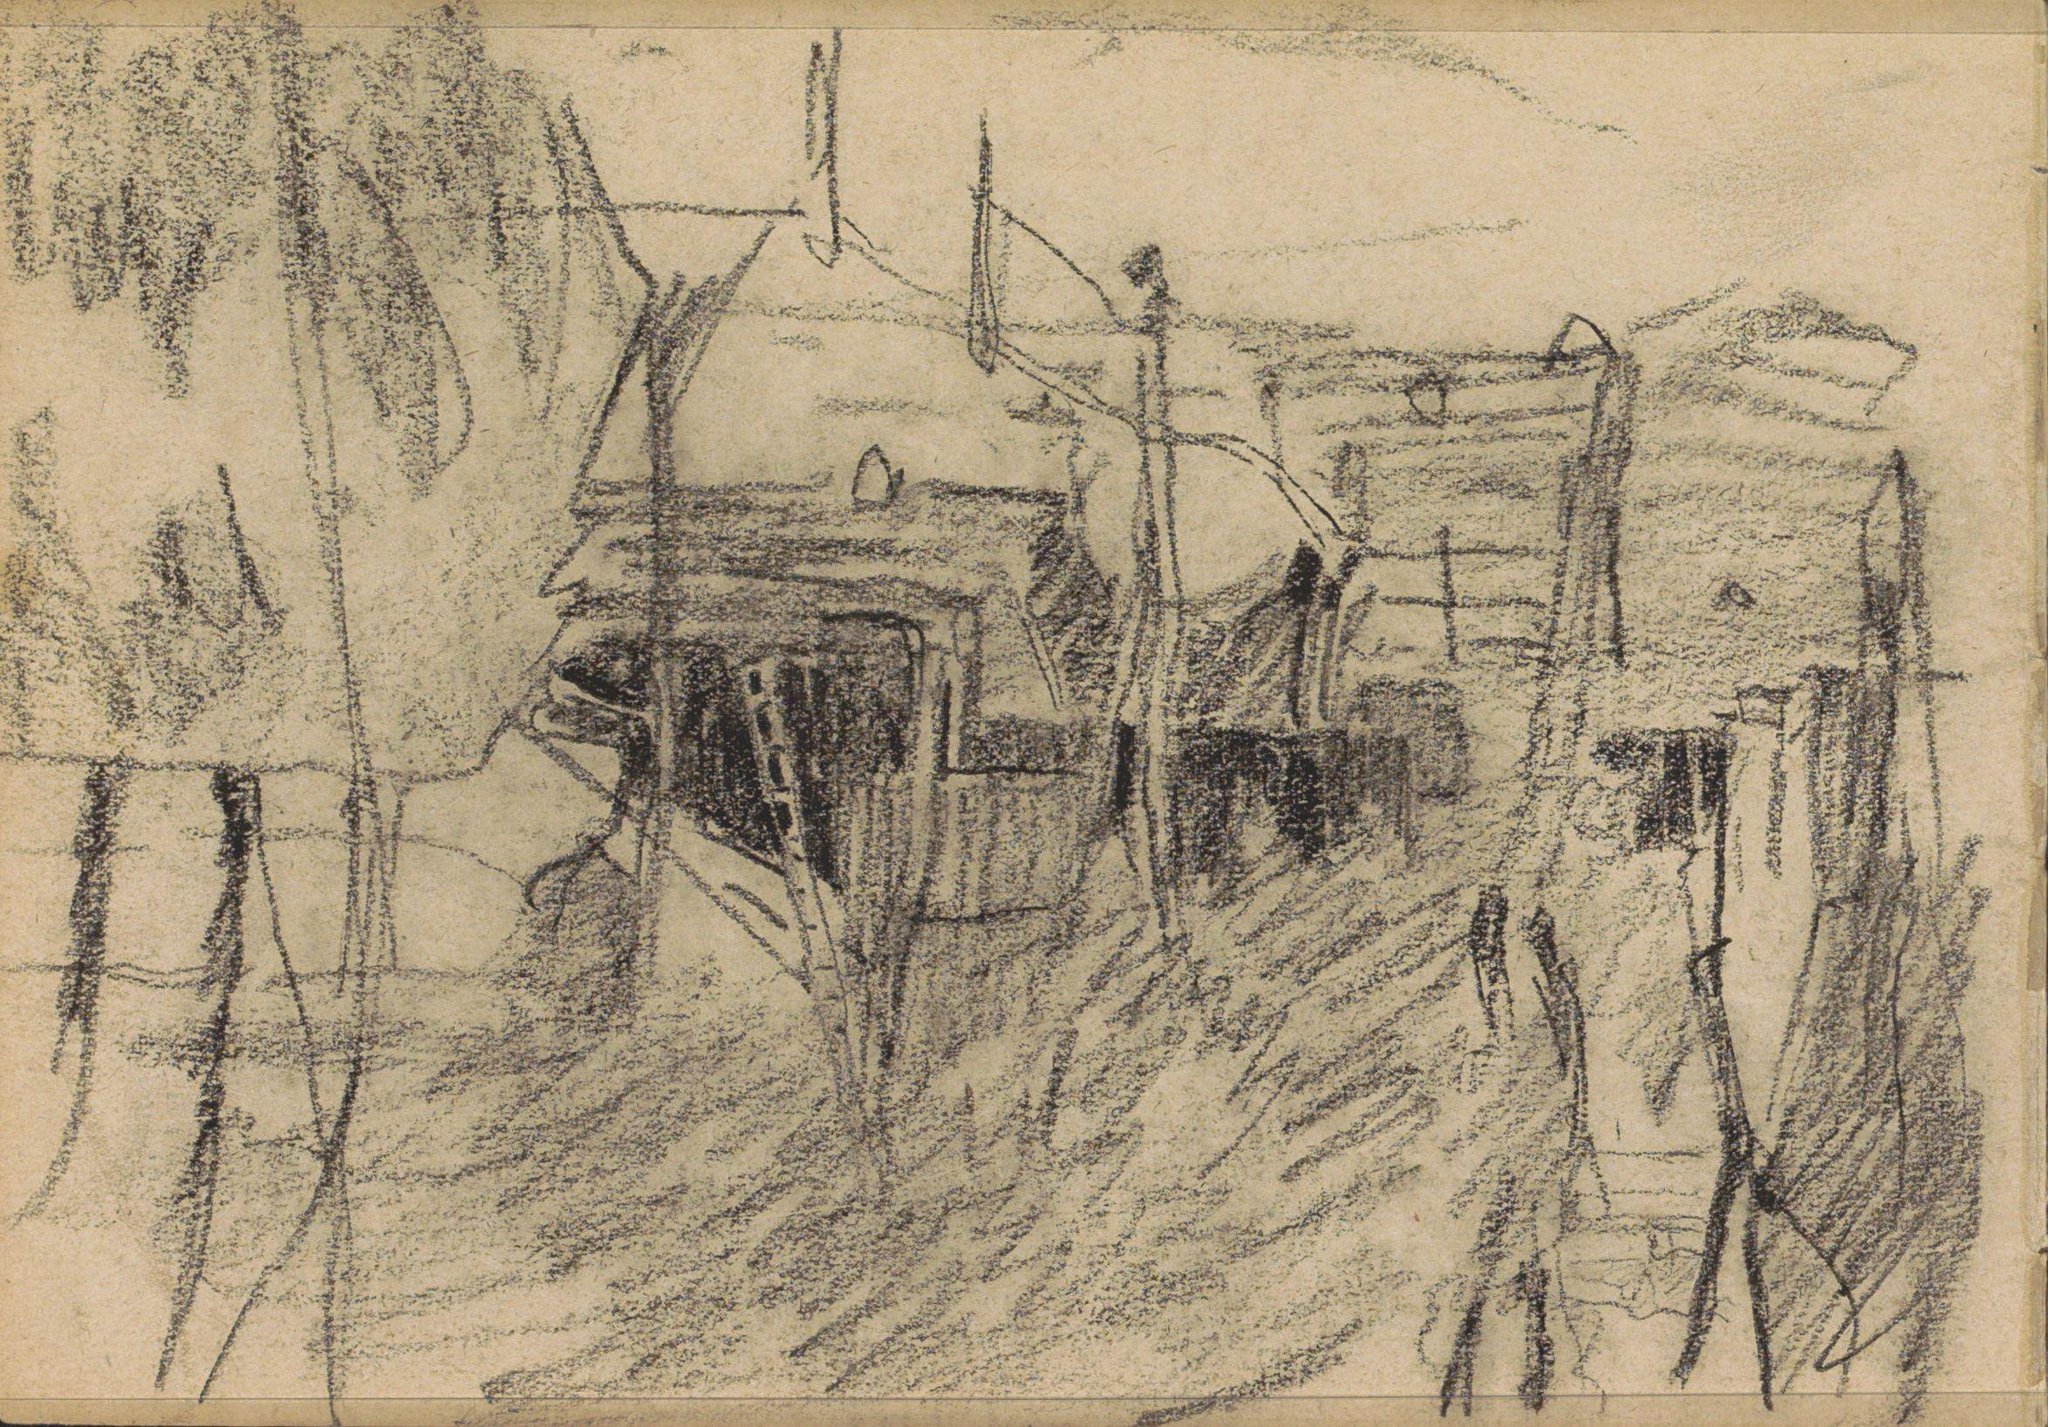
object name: sketchbook leaf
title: Landschap met bebouwing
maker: willem witsen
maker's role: draughtsman, painter, print maker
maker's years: 1860-1923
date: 1906-1907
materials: chalk, paper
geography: wijk bij duurstede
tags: landscapes, civic architecture; edifices; dwellings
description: Pagina 10 uit een schetsboek met 25 bladen.